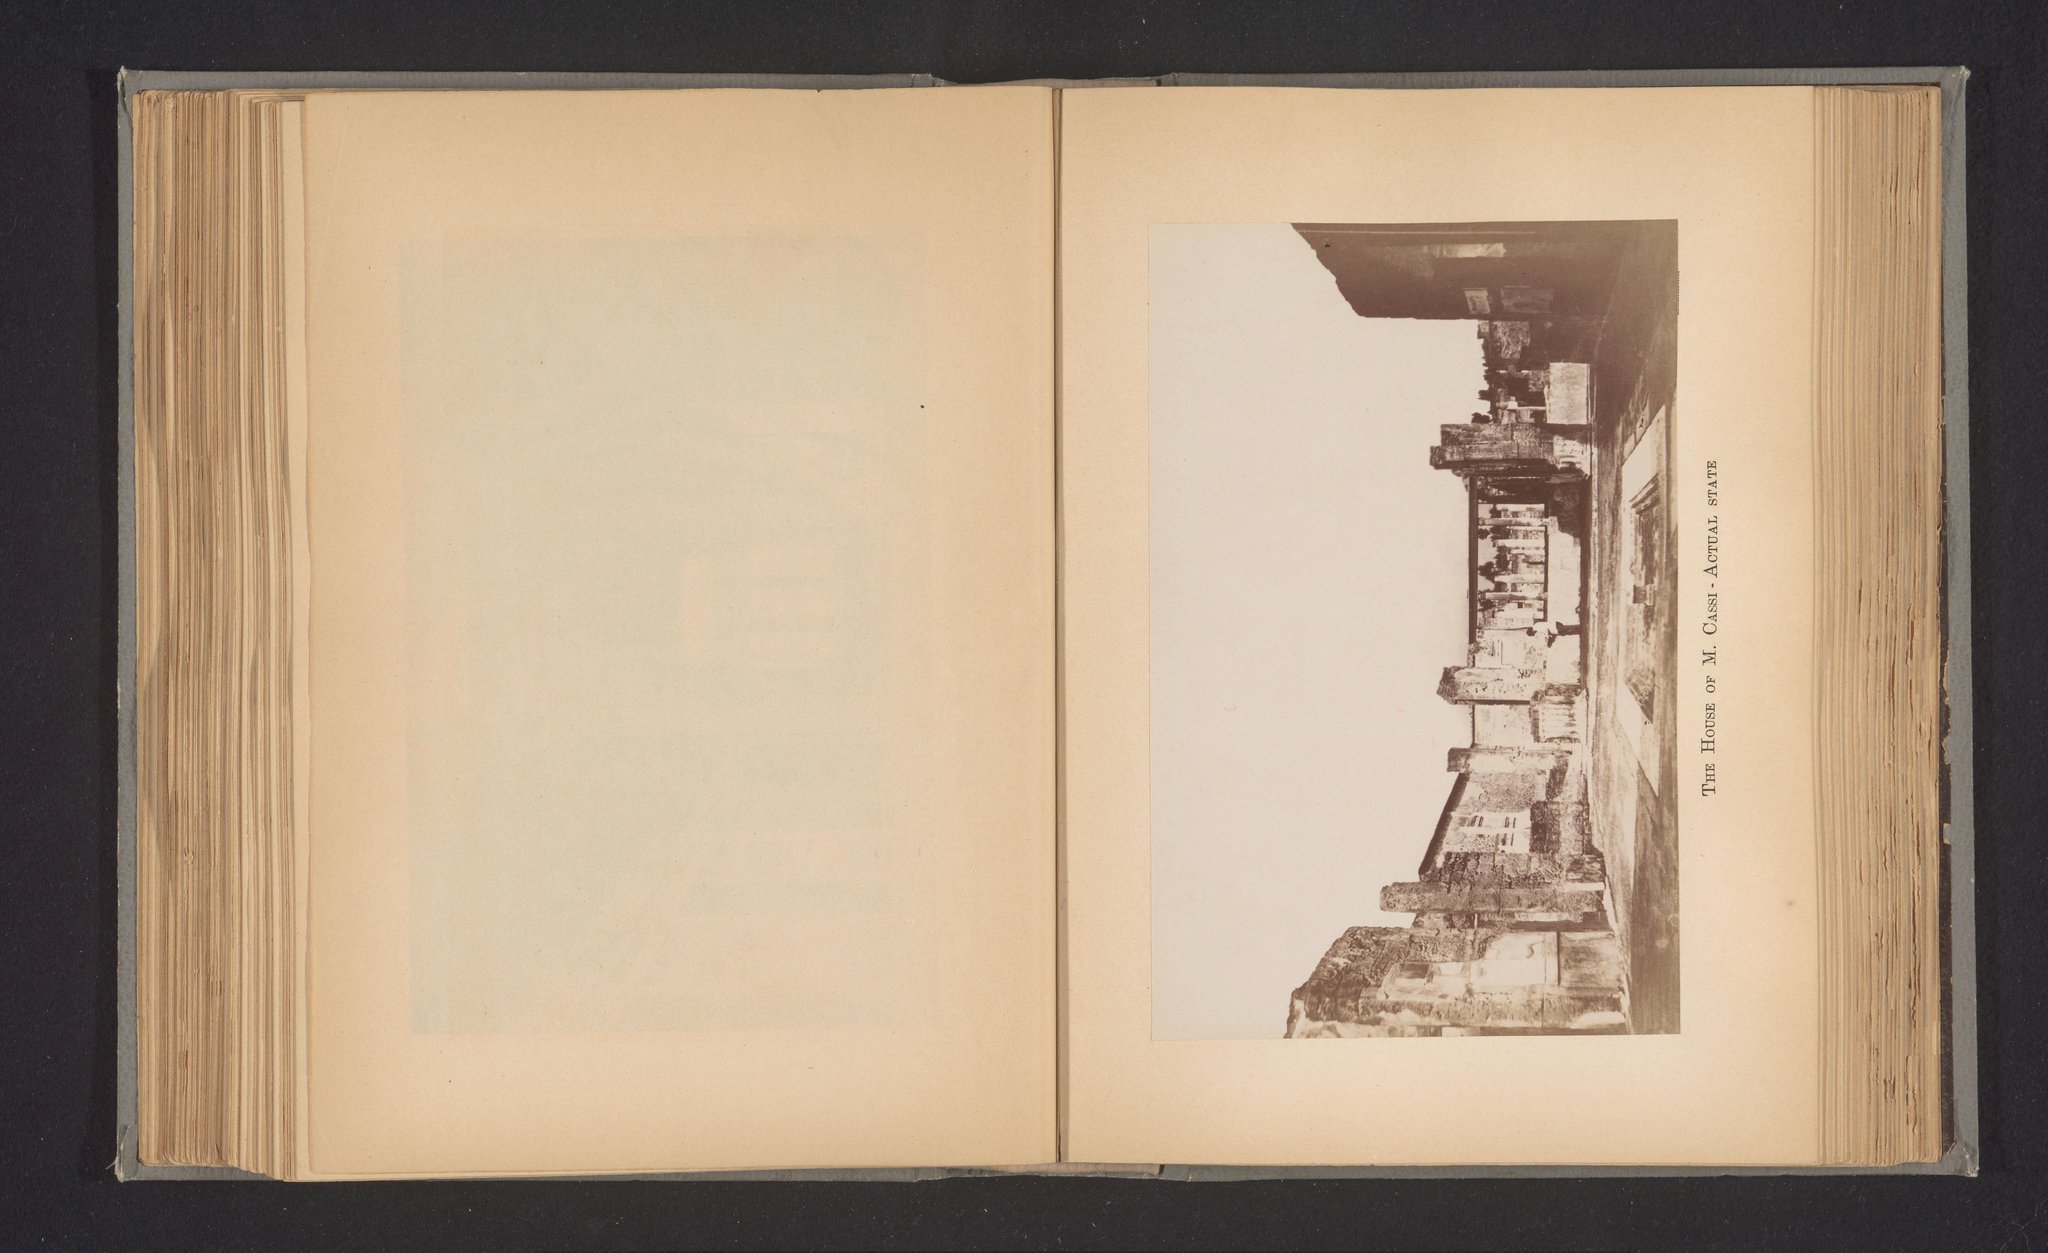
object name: photograph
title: The House of M. Cassi - Actual State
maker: Anonymous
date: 1890-1895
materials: photographic support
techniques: albumen print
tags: ruin of a building ~ architecture, pompeii